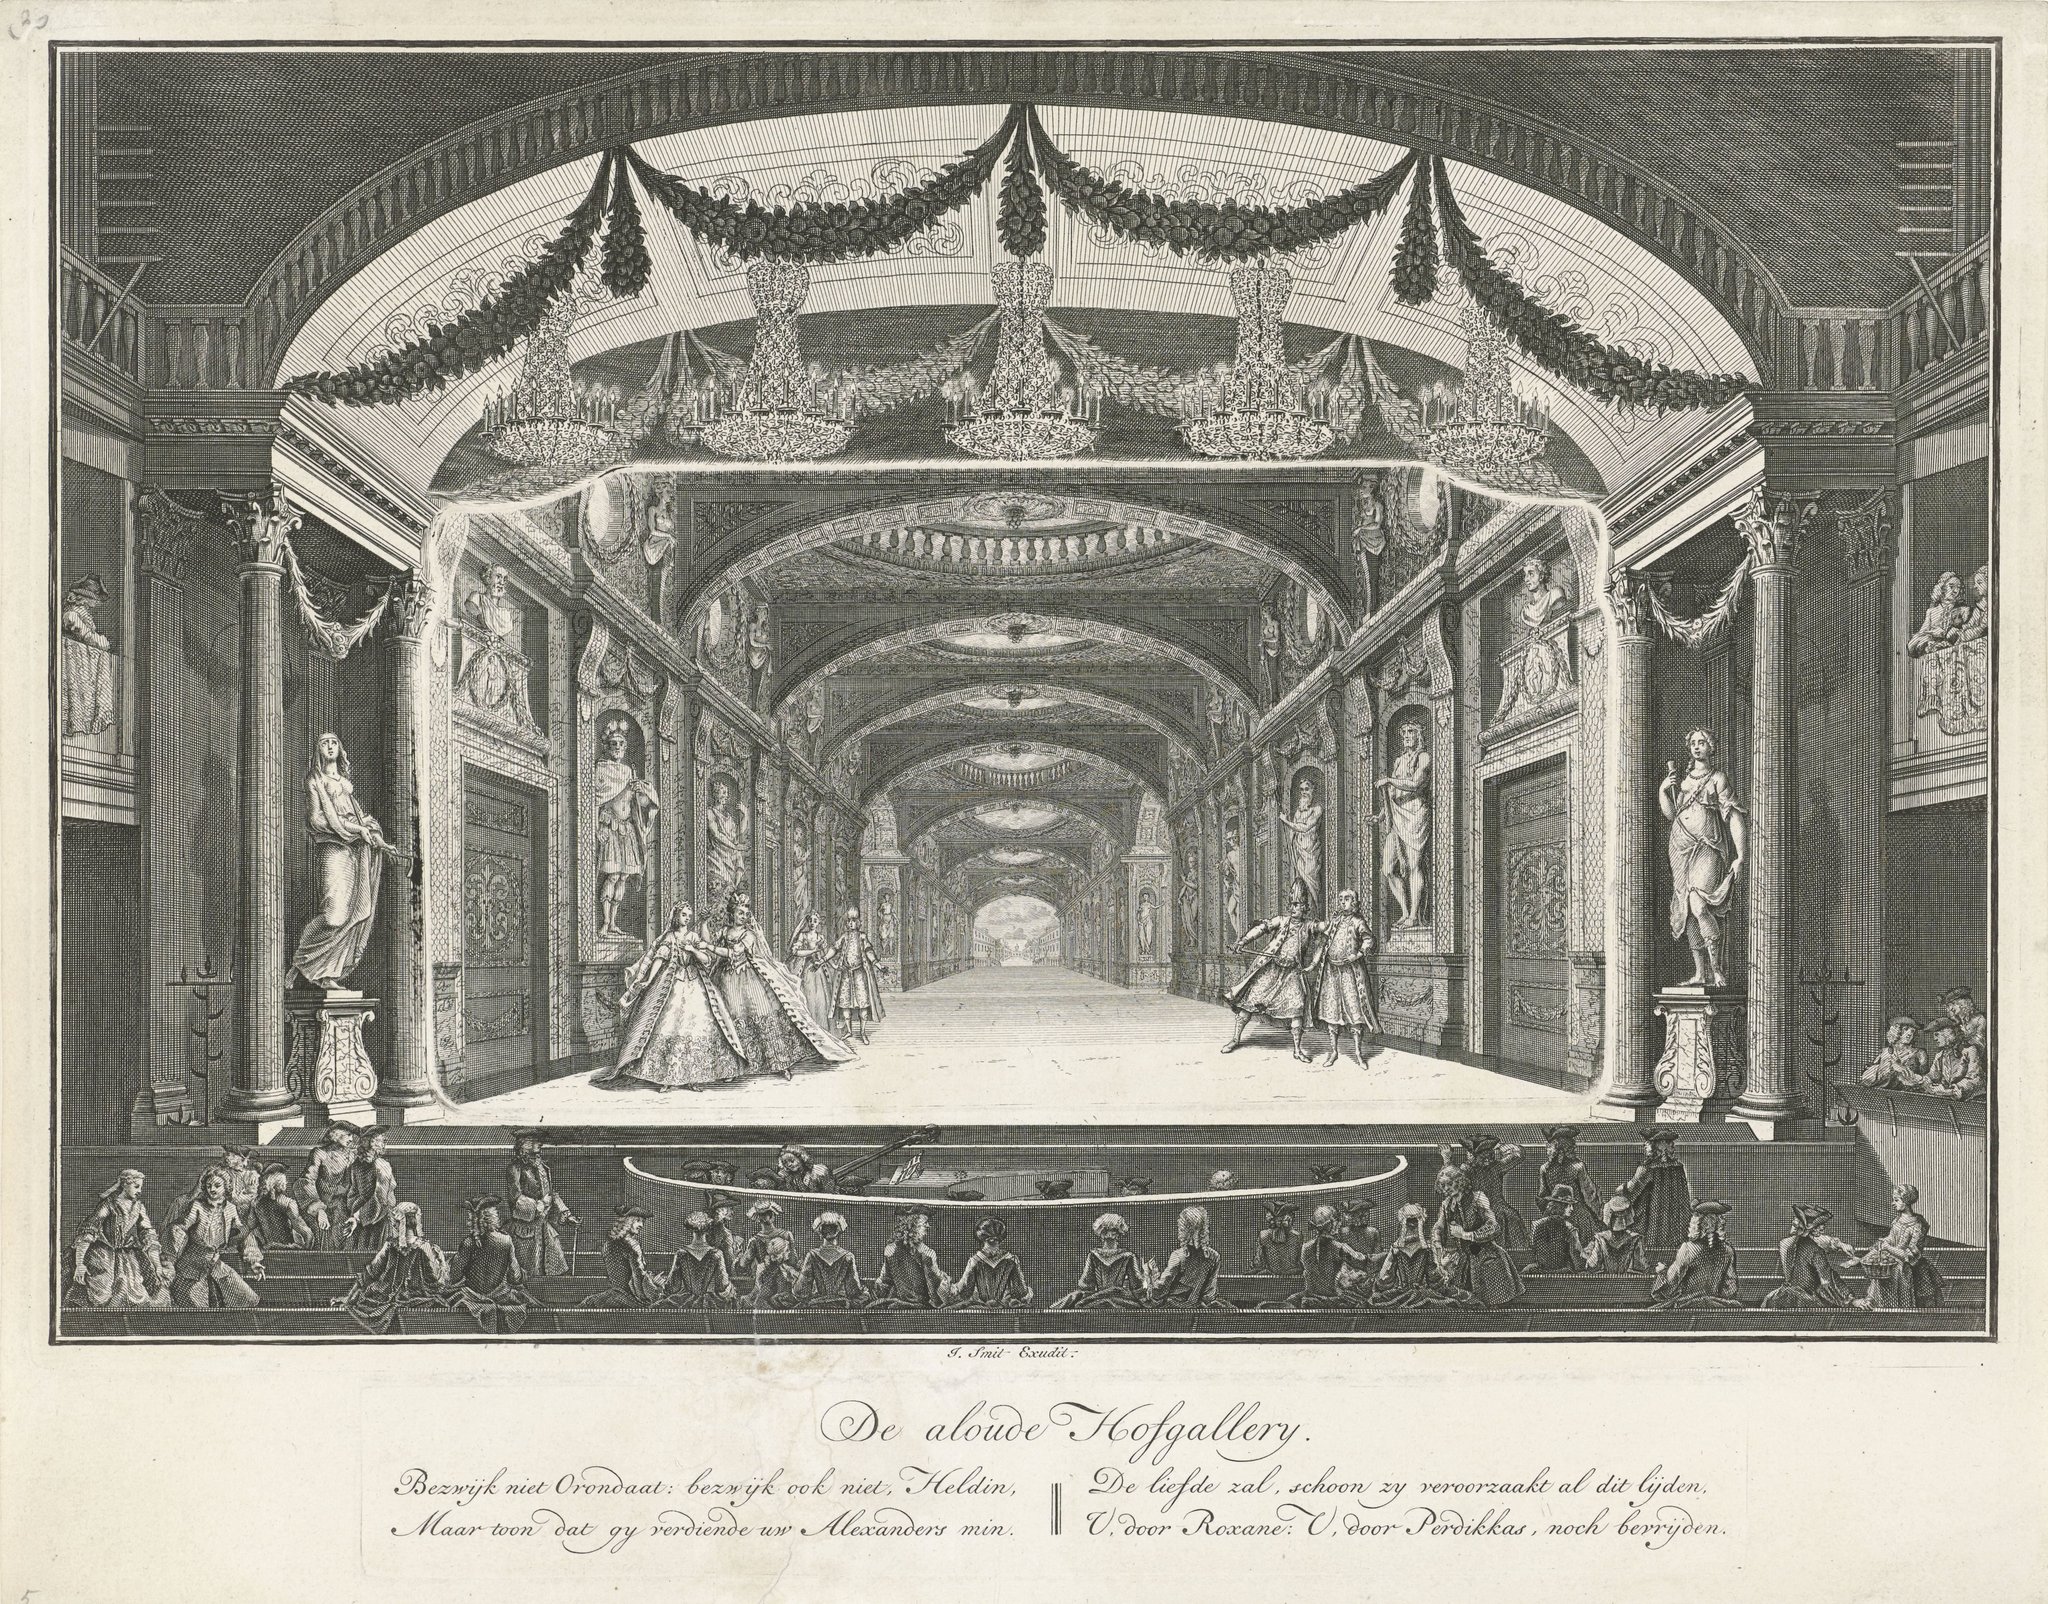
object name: print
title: Schouwburg met toneeldecor: De aloude Hofgallery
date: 1736-1738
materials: paper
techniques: engraving, etching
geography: amsterdam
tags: theatre, theatrical performance, stage design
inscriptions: collector's mark: Lugt 2228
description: Scène uit het toneelstuk "Het huwelyk van Orondates en Statira. Treurspel." door Jean Magnon (vertaald door D. Lingelbach), Amsterdam 1715. Deze platen zijn in verschillende groepen in verschillende periodes vervaardigd tussen 1738-1760 en uitgegeven in verschillende series ca. 1760 (met dit passe-partout) en ca. 1770-1772 (met een ander passe-partout). De platen zijn door Muller ingedeeld bij de platen van de brand van de Amsterdamse Schouwburg in 1772.